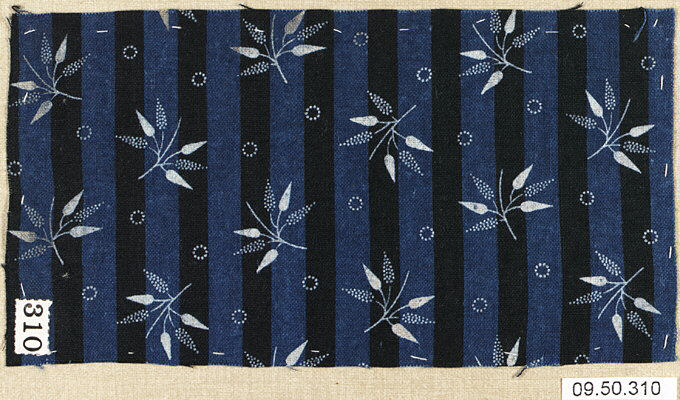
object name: piece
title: Piece (one of 116)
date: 1801-1900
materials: cotton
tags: leaves